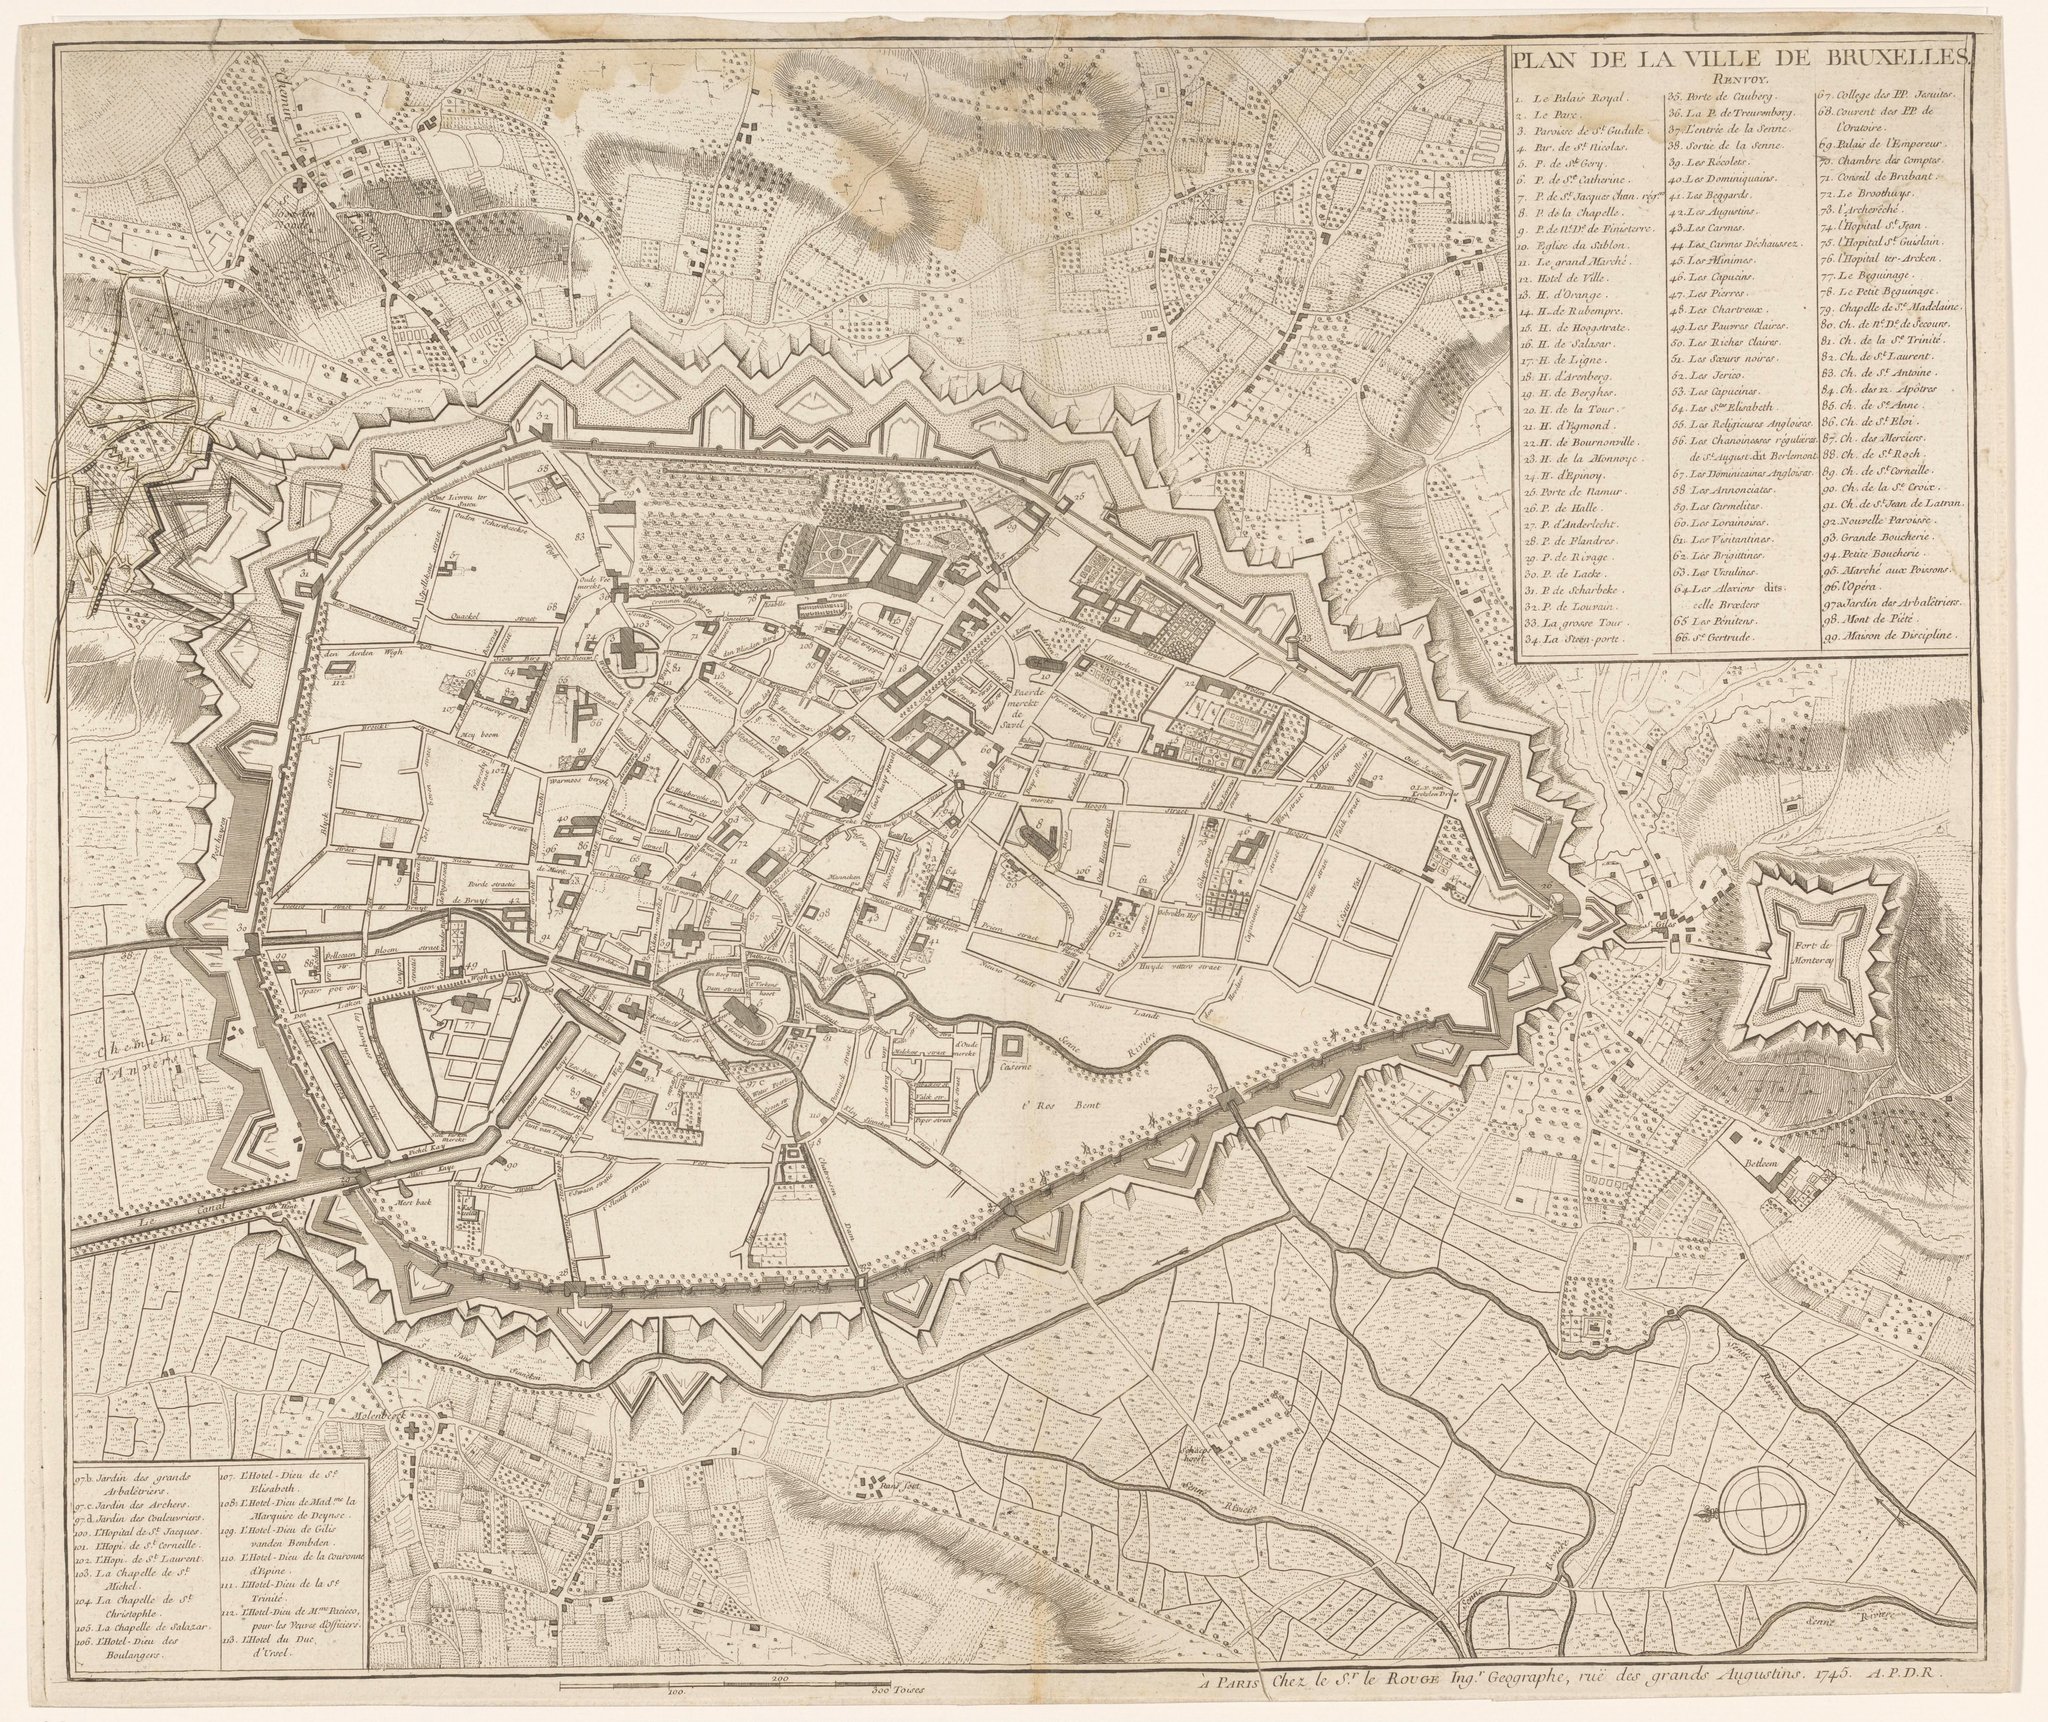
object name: area plan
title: Plattegrond van Brussel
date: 1745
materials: paper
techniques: engraving, etching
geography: paris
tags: fortified city, maps of cities, brussels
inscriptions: date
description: Plattegrond van Brussel. Rechtsboven een kader met titel en legenda 1-99. Linksonder een kader met het vervolg van de legenda, 97b-113. Onder de kaart, links van het midden, een schaalstok: 300 Toises.